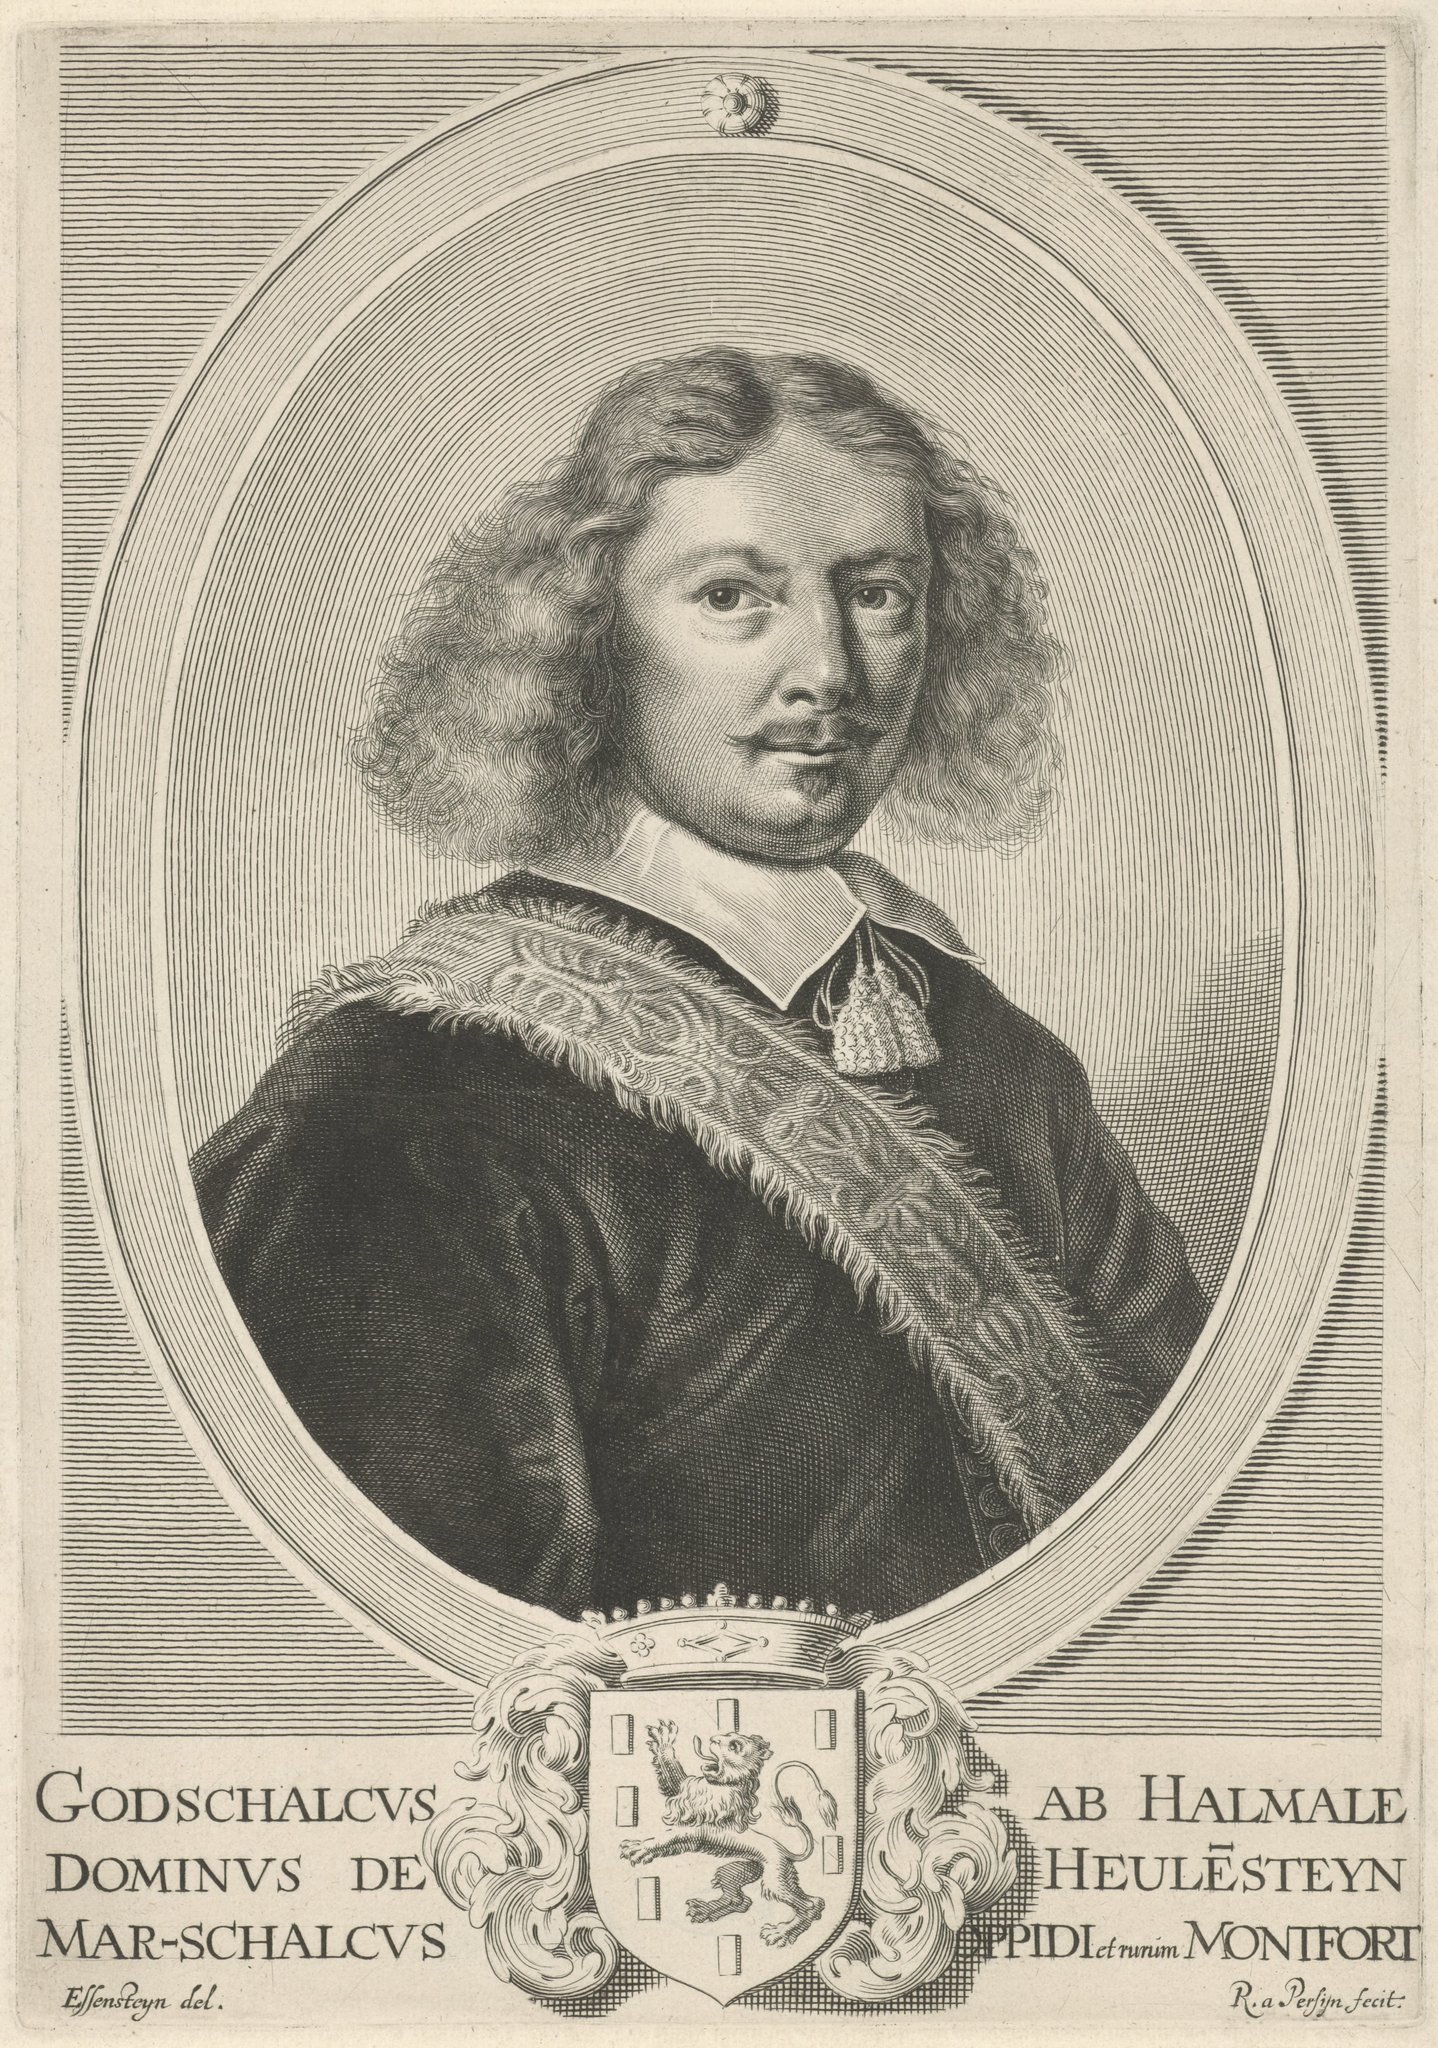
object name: print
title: Portret van Godschalck van Halmale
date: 1623-1668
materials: paper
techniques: engraving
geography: gouda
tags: maarschalk, godschalck van halmale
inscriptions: collector's mark: Lugt 2228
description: Portret van Godschalck van Halmale, heer van Heulestein, maarschalk van Montfoort. In de marge het wapenschild van de geportretteerde en een drieregelig onderschrift met de naam en functie van de geportretteerde in het Latijn.